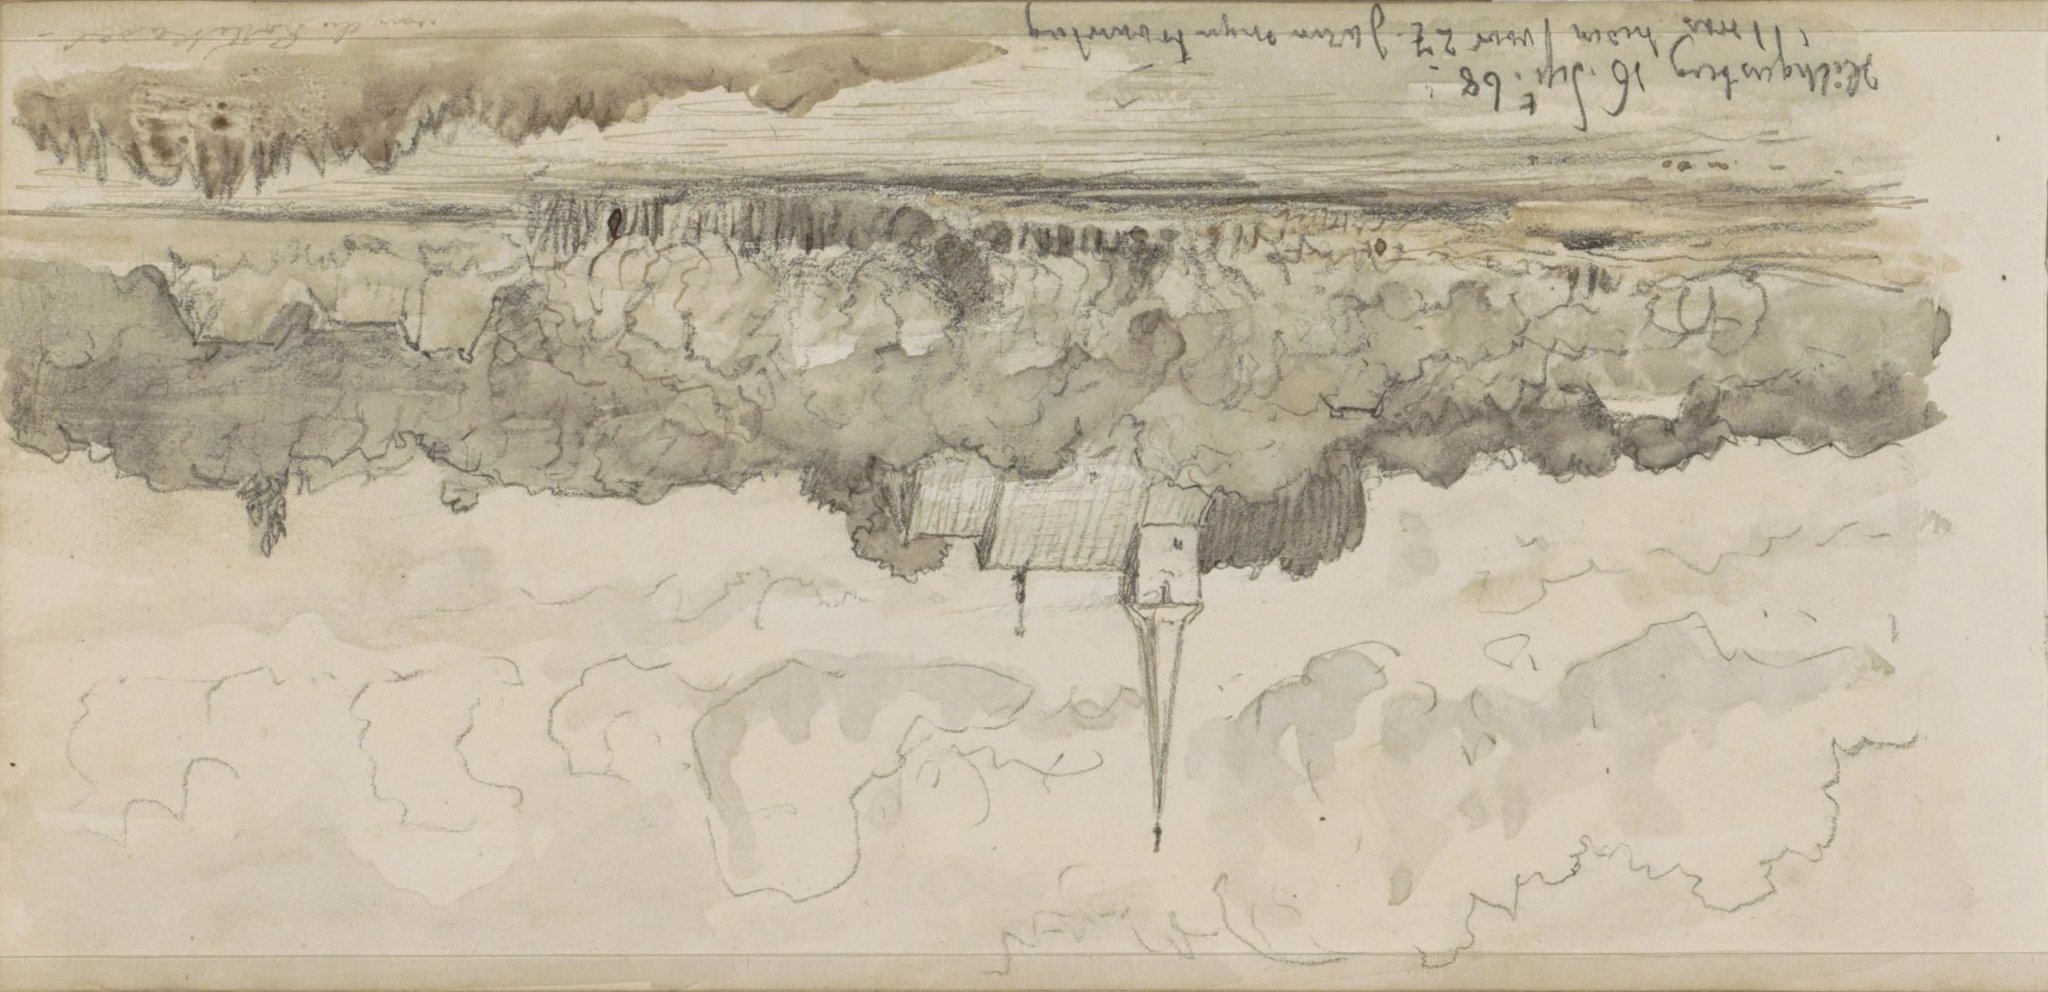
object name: sketchbook leaf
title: Gezicht op Hillegersberg met de Hillegondakerk vanaf de Rottekade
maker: johannes tavenraat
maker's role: draughtsman, painter, print maker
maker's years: 1809-1881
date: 1809-1868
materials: paper, pencil, watercolor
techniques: brush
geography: hillegersberg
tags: city-view, and landscape with man-made constructions, landscapes with waters, waterscapes, seascapes (in the temperate zone), church (exterior)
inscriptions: date and inscription: ‘Hilligersberg 16. Sept. 1868/ 't was heden voor 27 jaren mijn trouwdag/ van de Rottekade’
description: Blad 30 verso uit een schetsboek met 63 bladen.